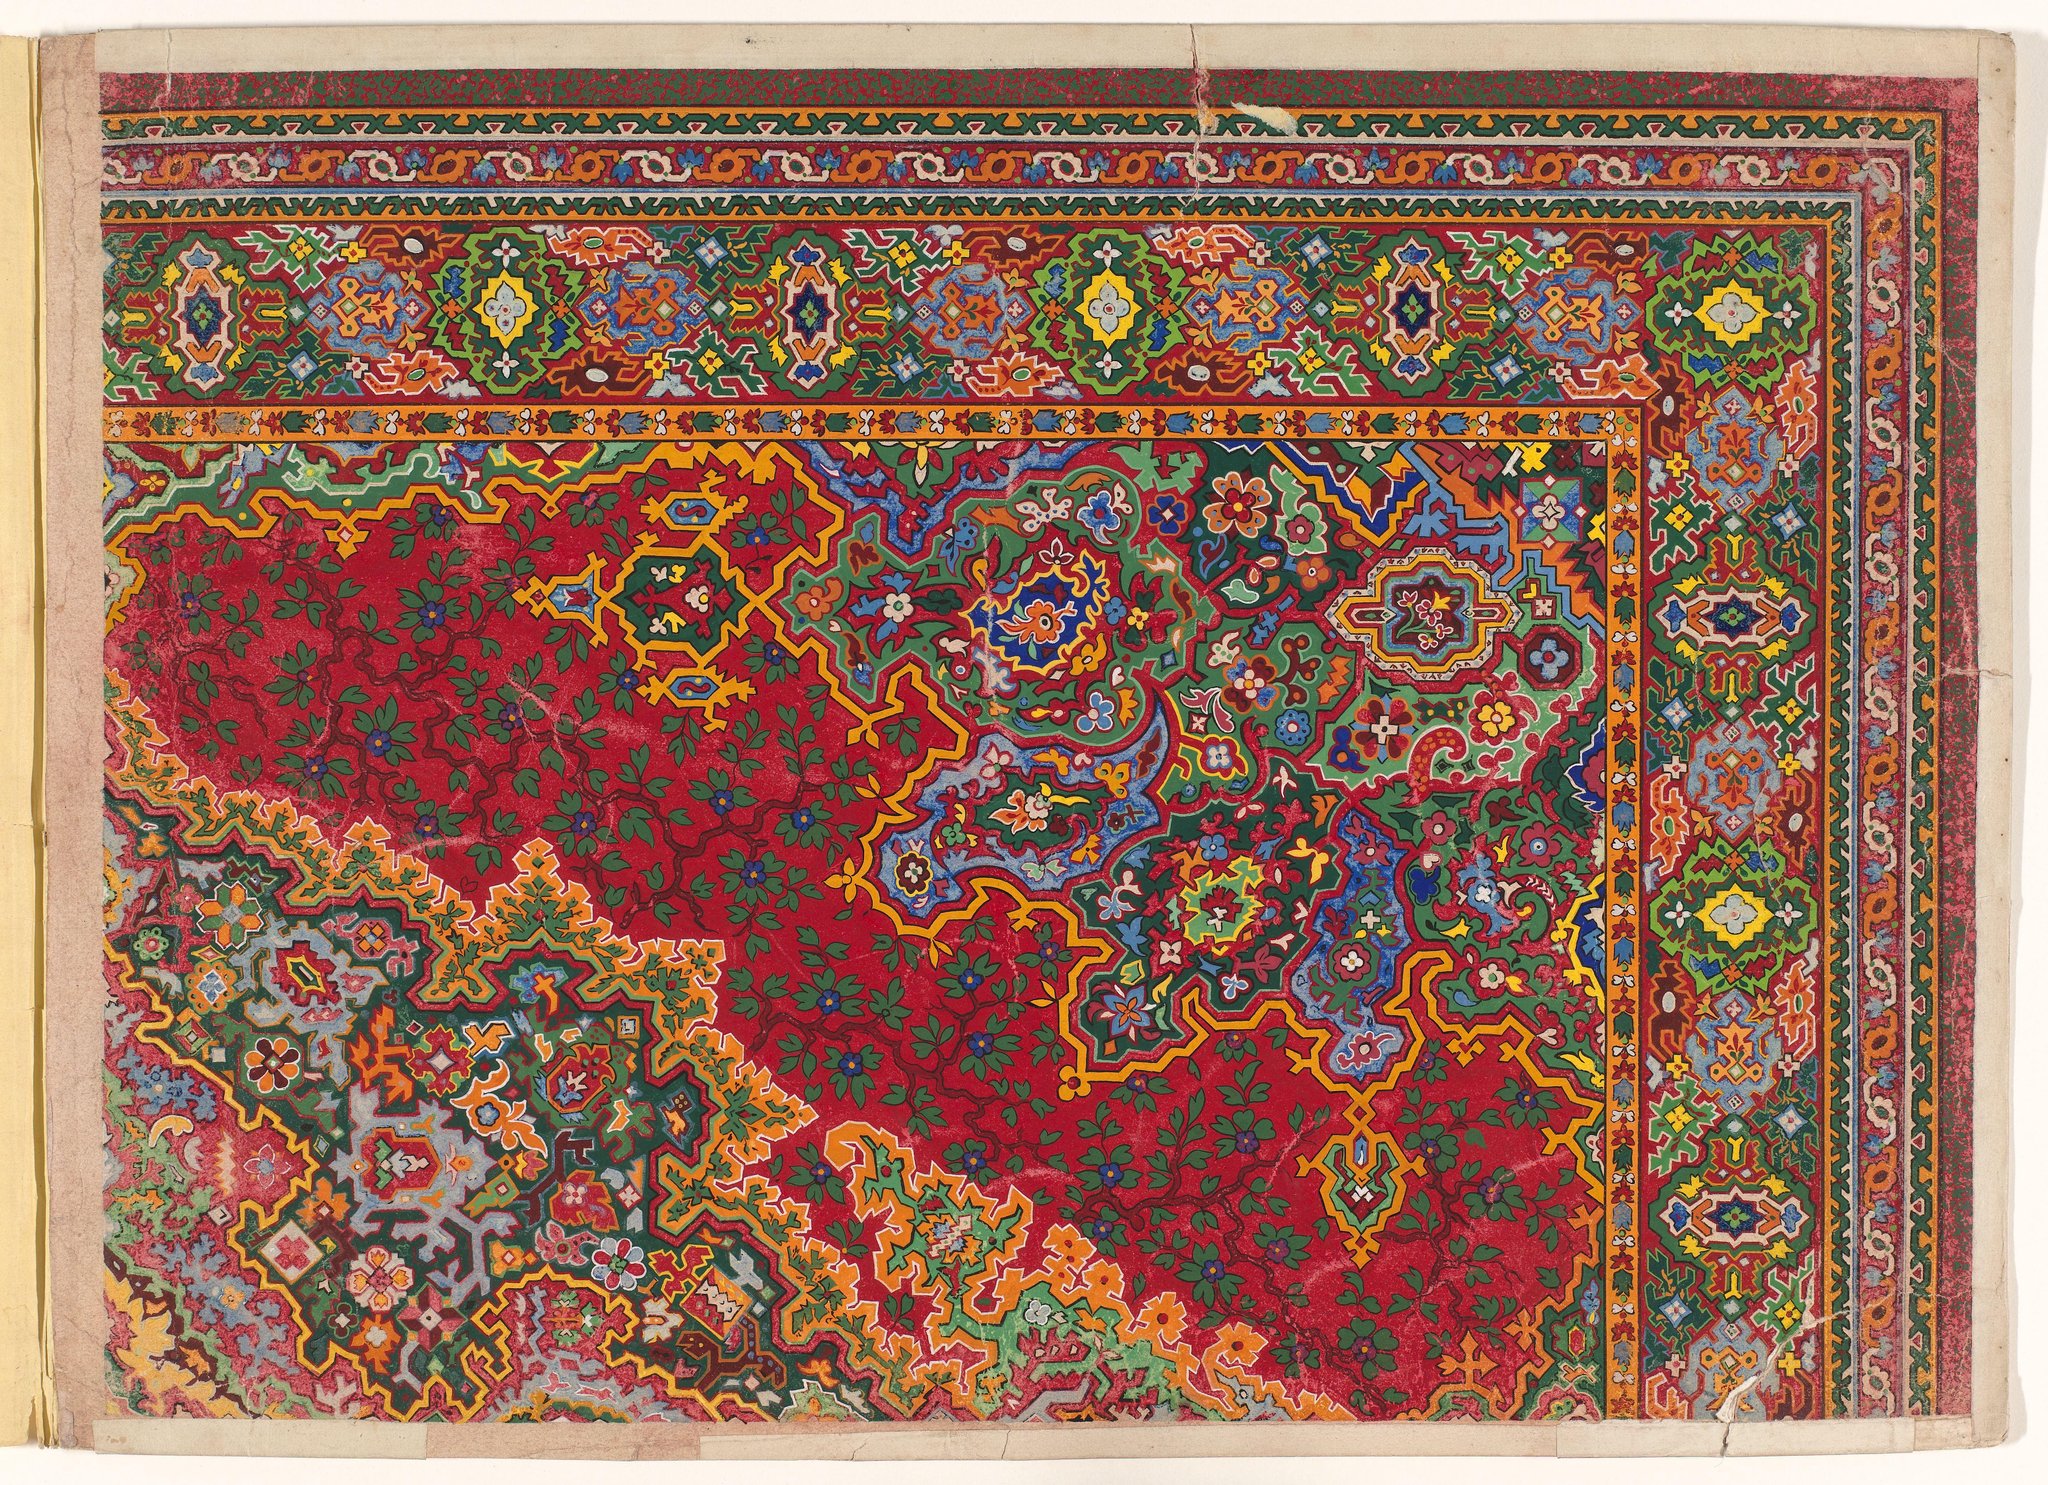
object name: drawing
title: Ontwerp voor een tapijt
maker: Anonymous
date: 1854-1864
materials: gouache, paper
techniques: brush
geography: deventer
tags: ornaments ~ art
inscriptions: inscription: ‘W/ I’, inscription: ‘V.P.’, retailer's mark: ‘JHS.’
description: De presentatietekeningen BK-1971-77-1 t/m 86 zijn kopieën van de originele ontwerptekeningen. Ze werden gemaakt voor vertegenwoordigers van bijvoorbeeld magazijnen, die ze aan hun klanten konden tonen. De meeste tekeningen tonen een kwart van het dessin inclusief rand, middenpartij (de zogenaamde grond of fond) en centraal medaillon. Door het gebruik van spiegels kan de illusie van het gehele tapijt worden opgeroepen. Een deel van de tekeningen heeft een alfabetische opeenvolgende letter als kenmerk, de andere groep een cijfer.Waarschijnlijk is de reeks dessins met een letter eerder samengesteld dan de genummerde tekeningen.